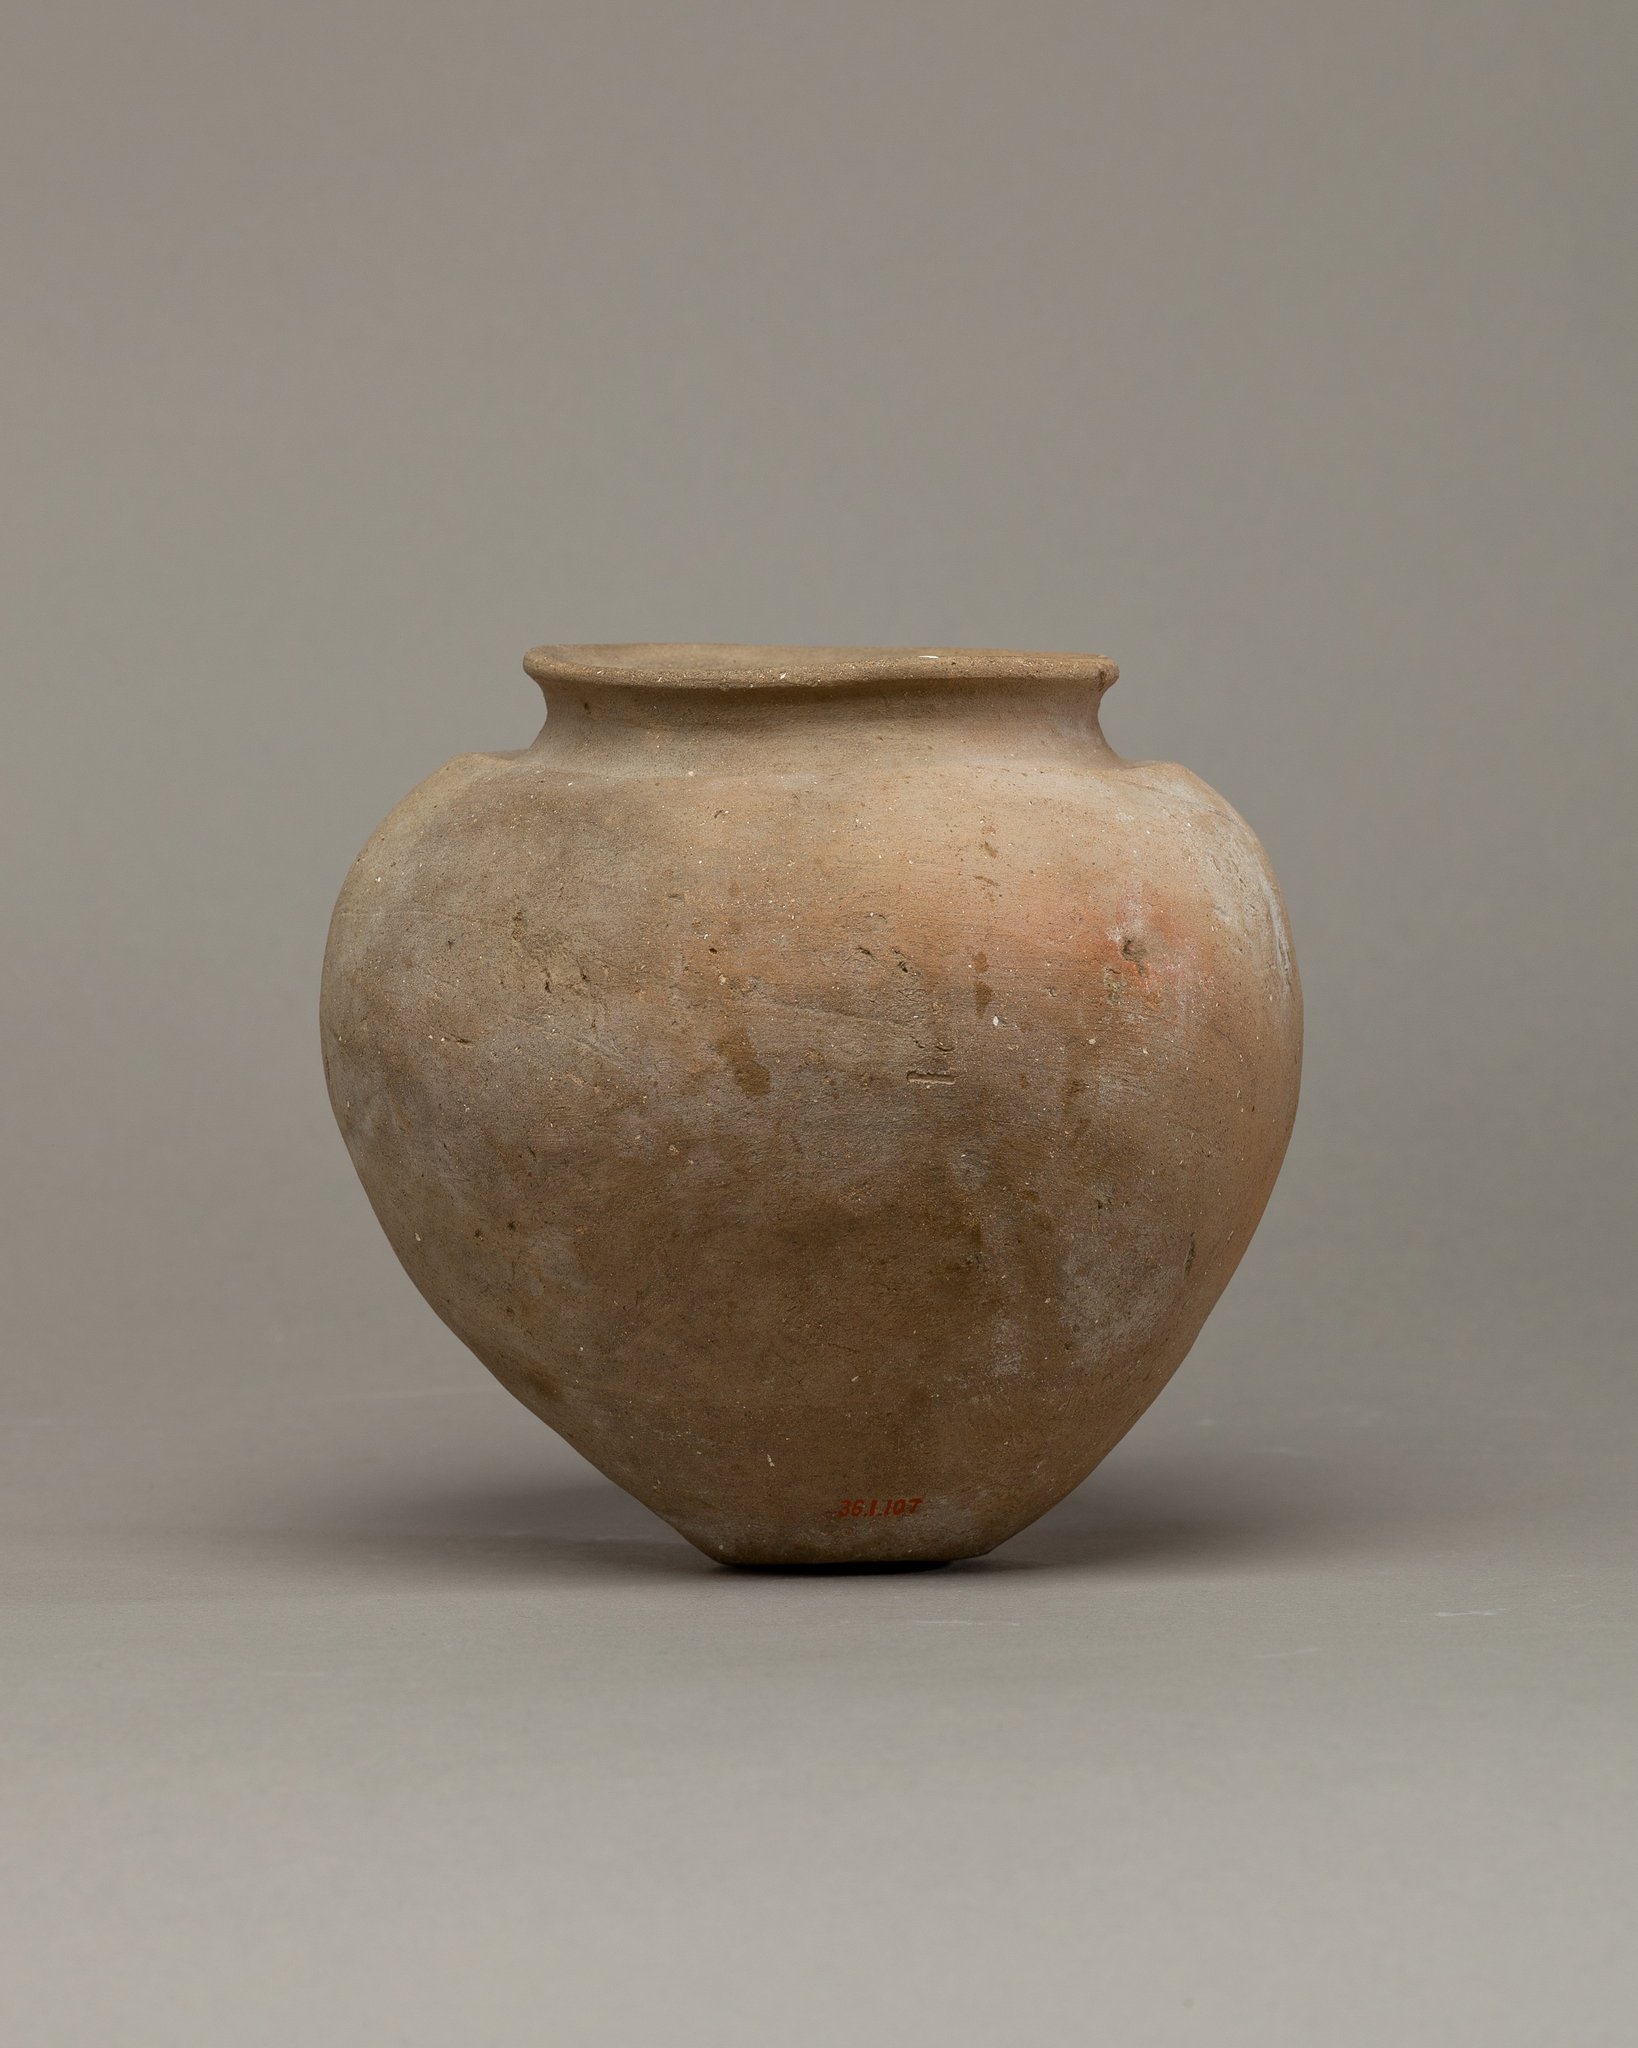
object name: jar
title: Unevenly made jar of desert clay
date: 3850-2960 BCE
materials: pottery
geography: egypt